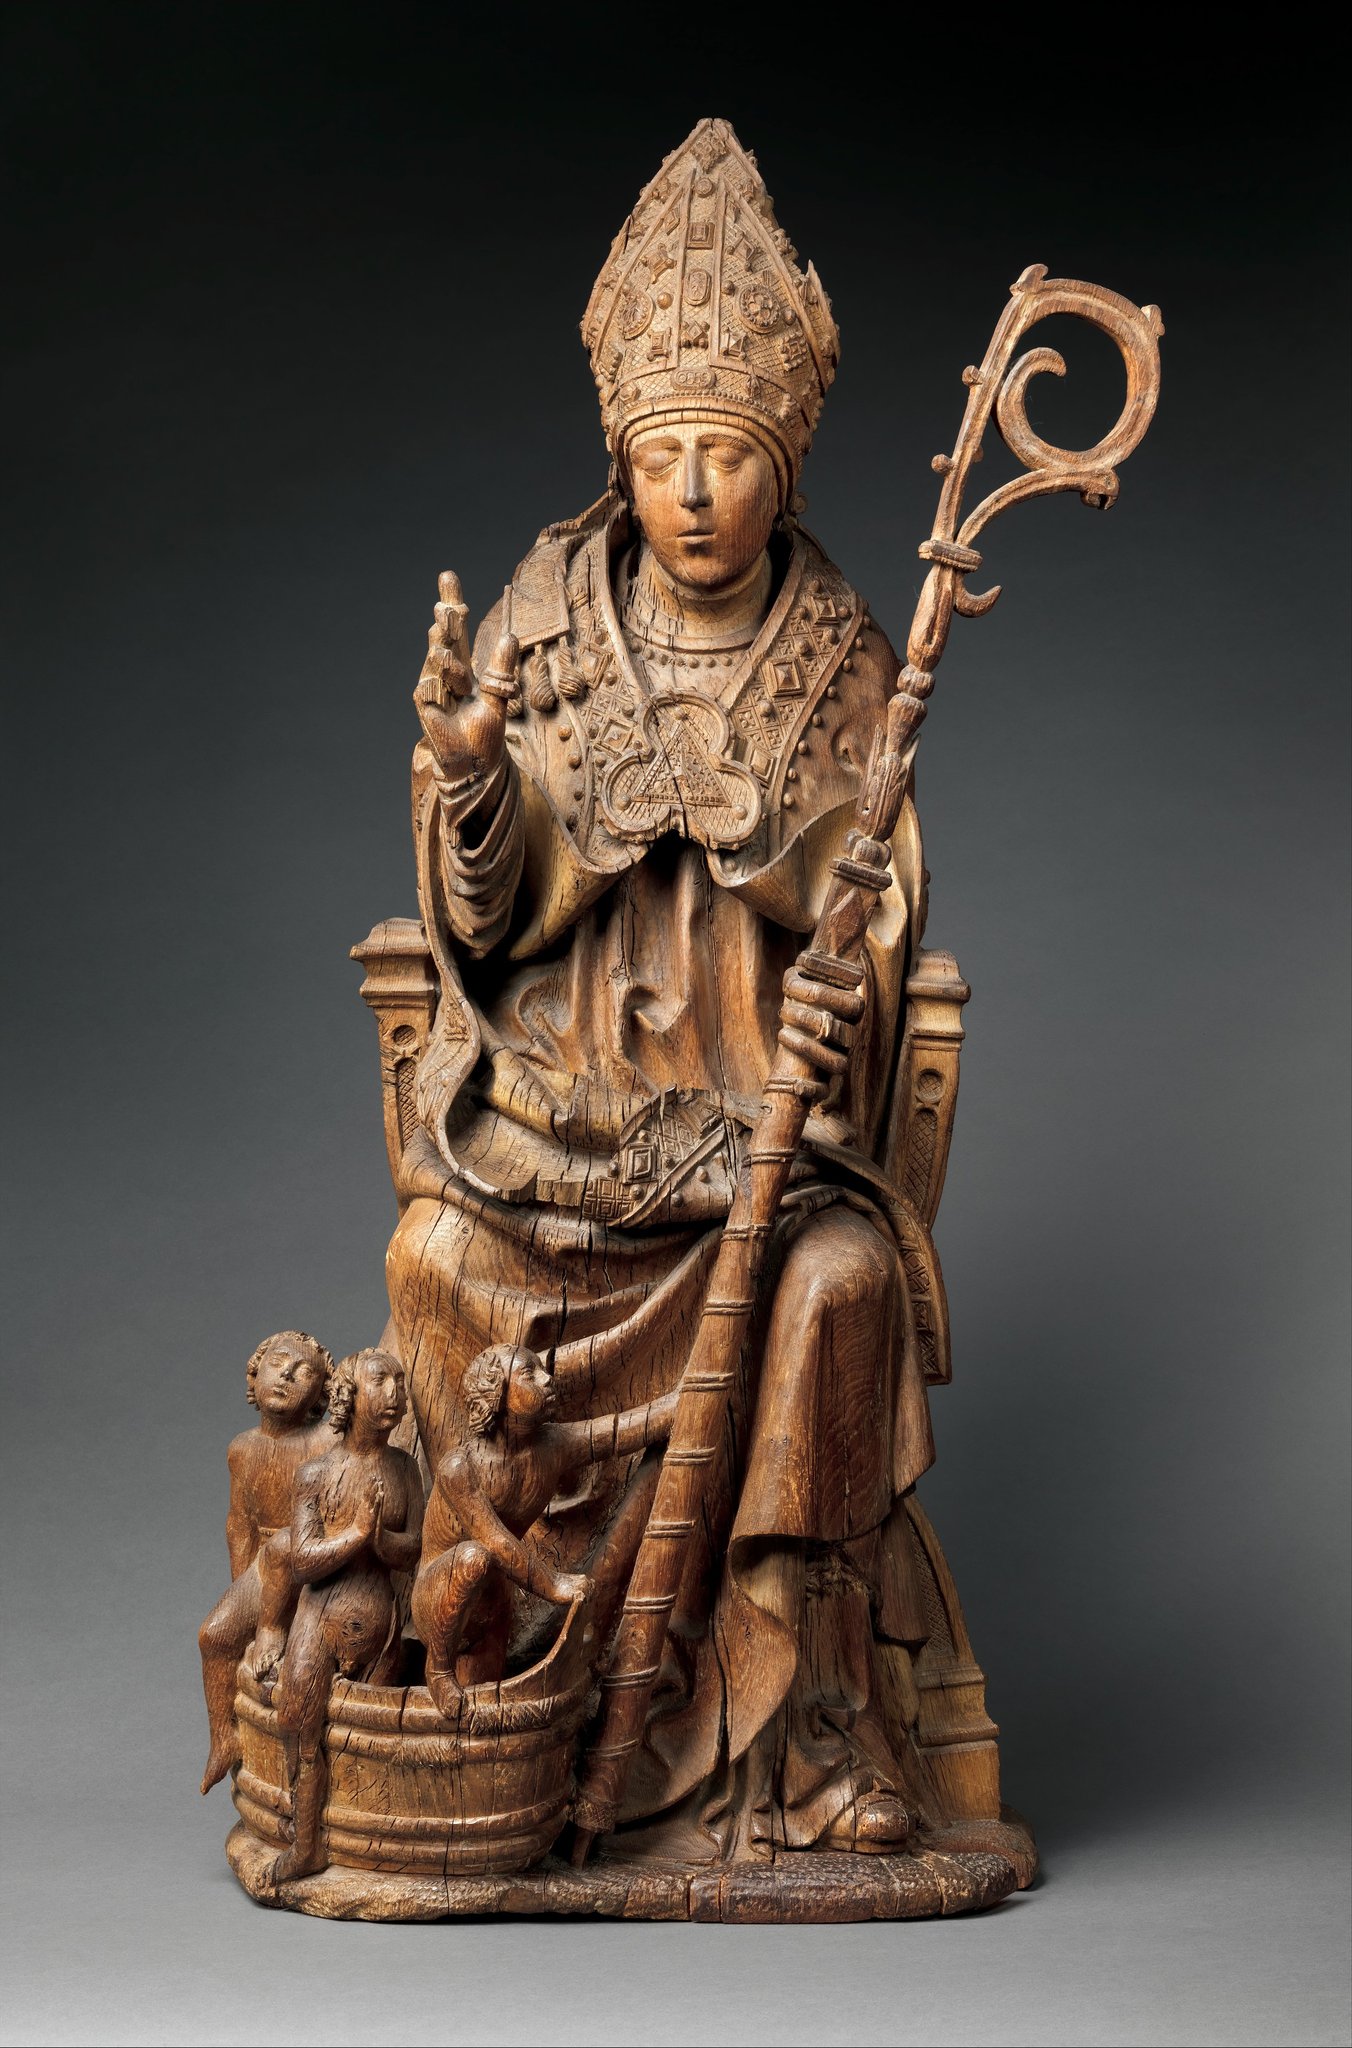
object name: statue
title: Saint Nicholas with the Three Boys in the Pickling Tub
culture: south netherlandish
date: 1500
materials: wood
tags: boys